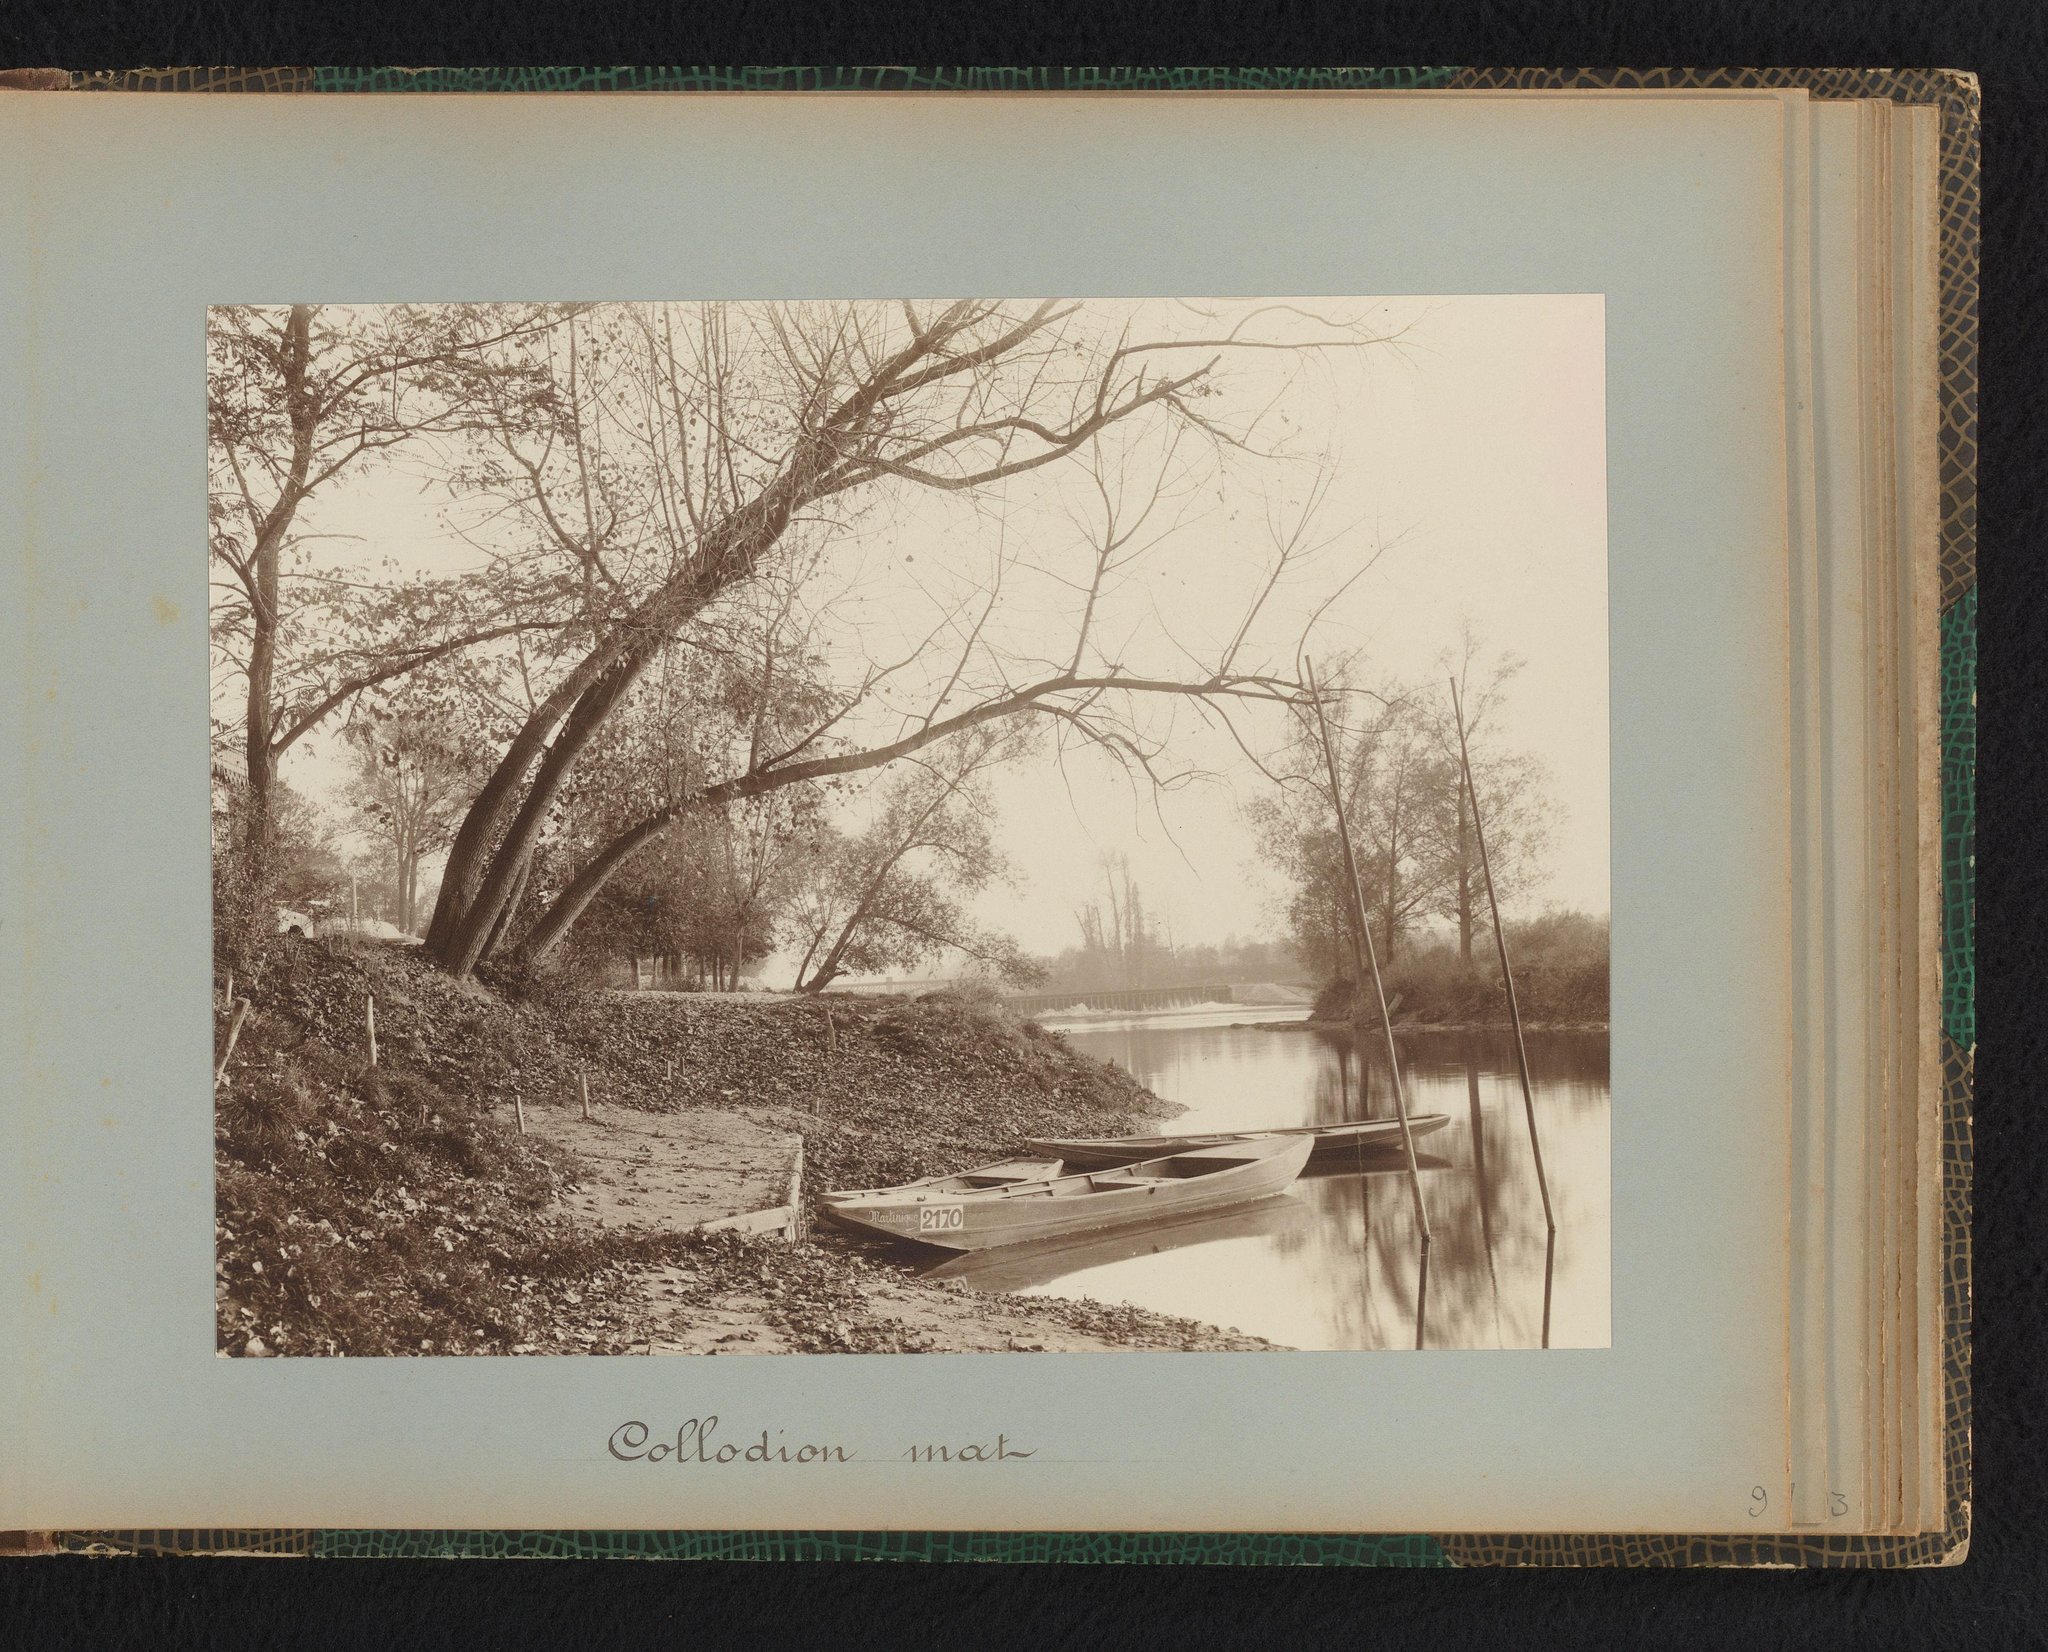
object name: page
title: Gezicht op een meer met twee roeiboten aan de kant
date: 1890-1910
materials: paper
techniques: matte daylight collodion silver print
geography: paris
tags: moustache, lake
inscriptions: inscription: ‘Collodion mat’